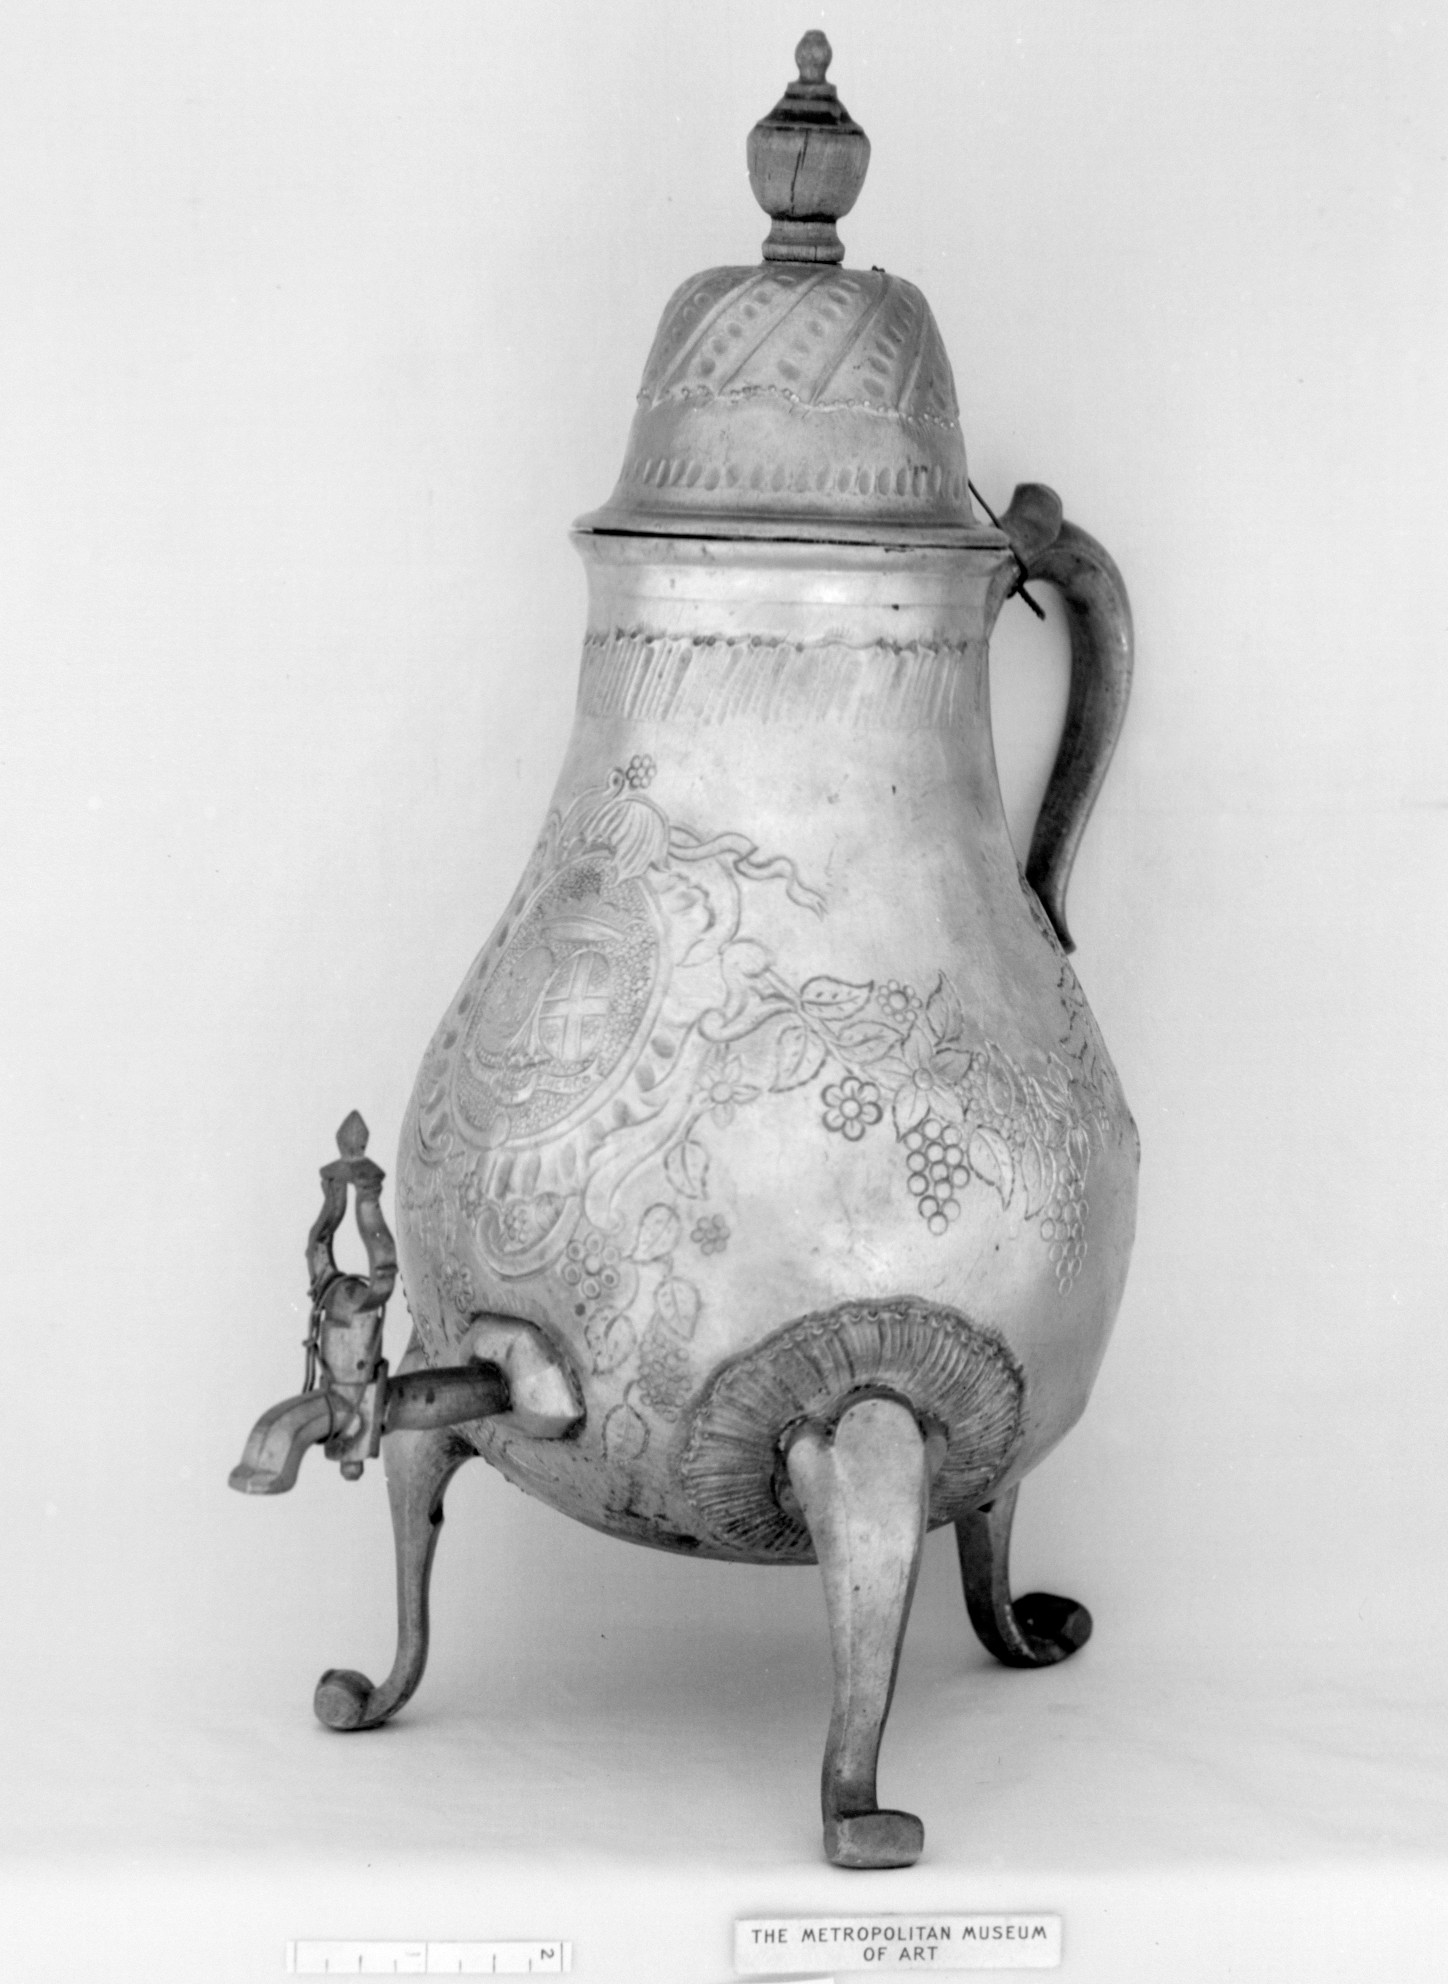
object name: urn with cover and tray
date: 1701-1800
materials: brass, pewter, wood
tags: grapes,insignia